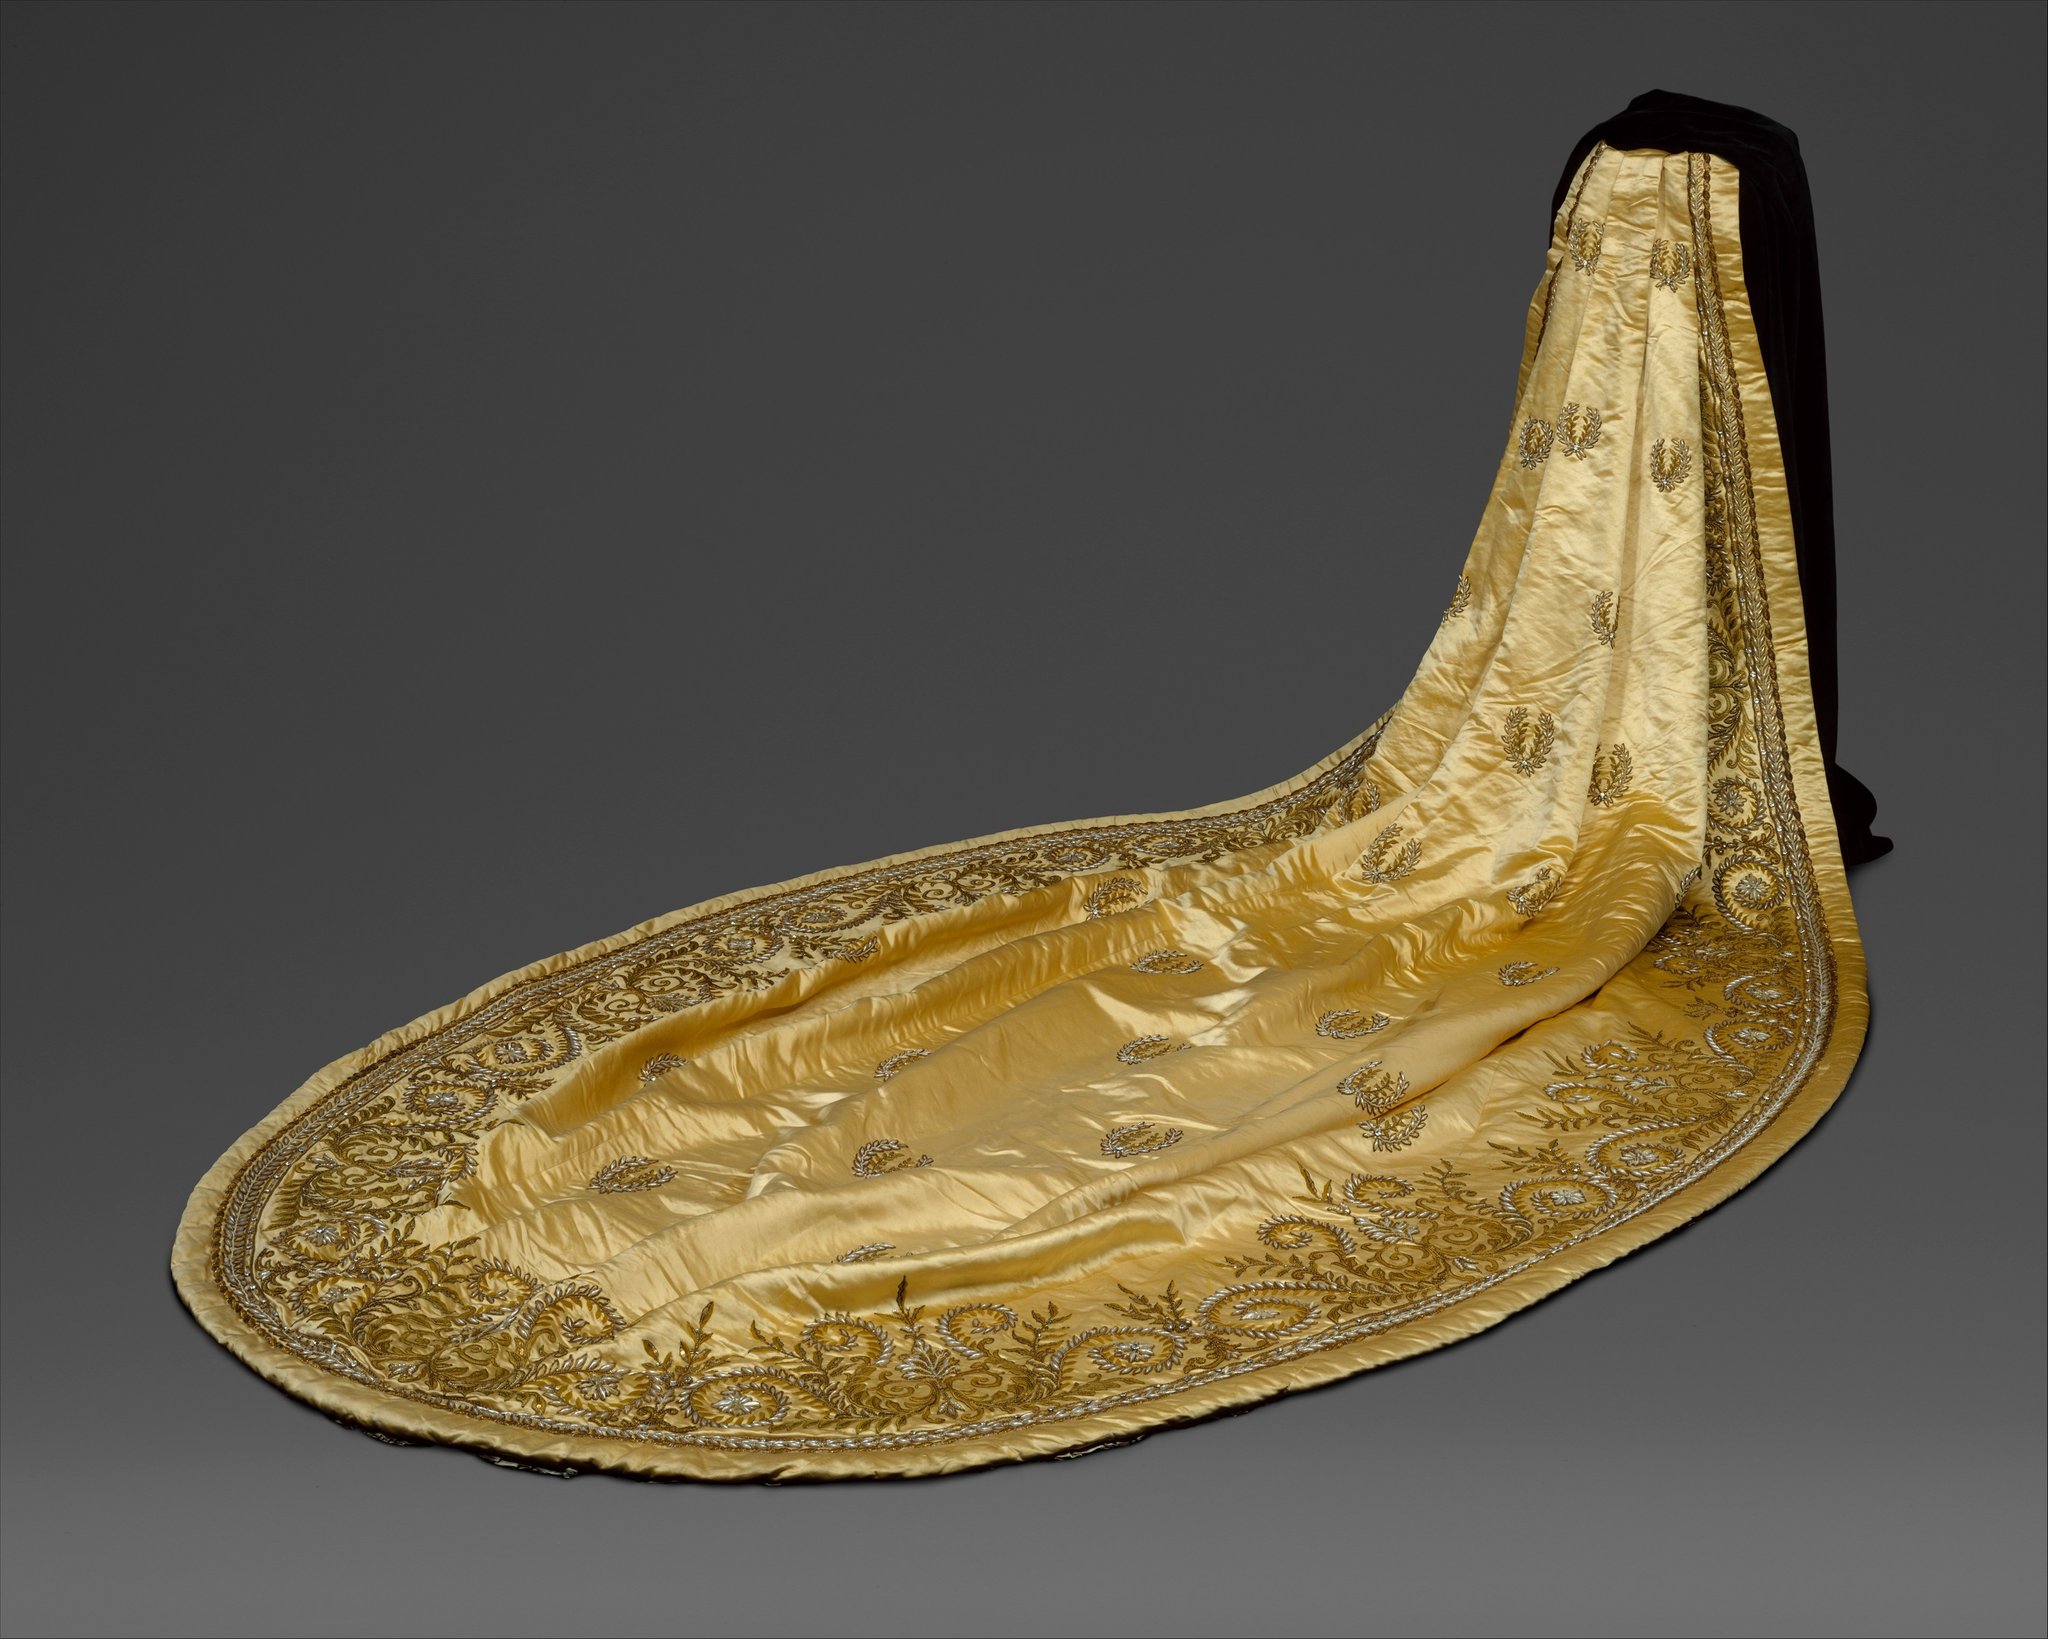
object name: court train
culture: french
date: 1860-1869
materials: bronze, glass, silk